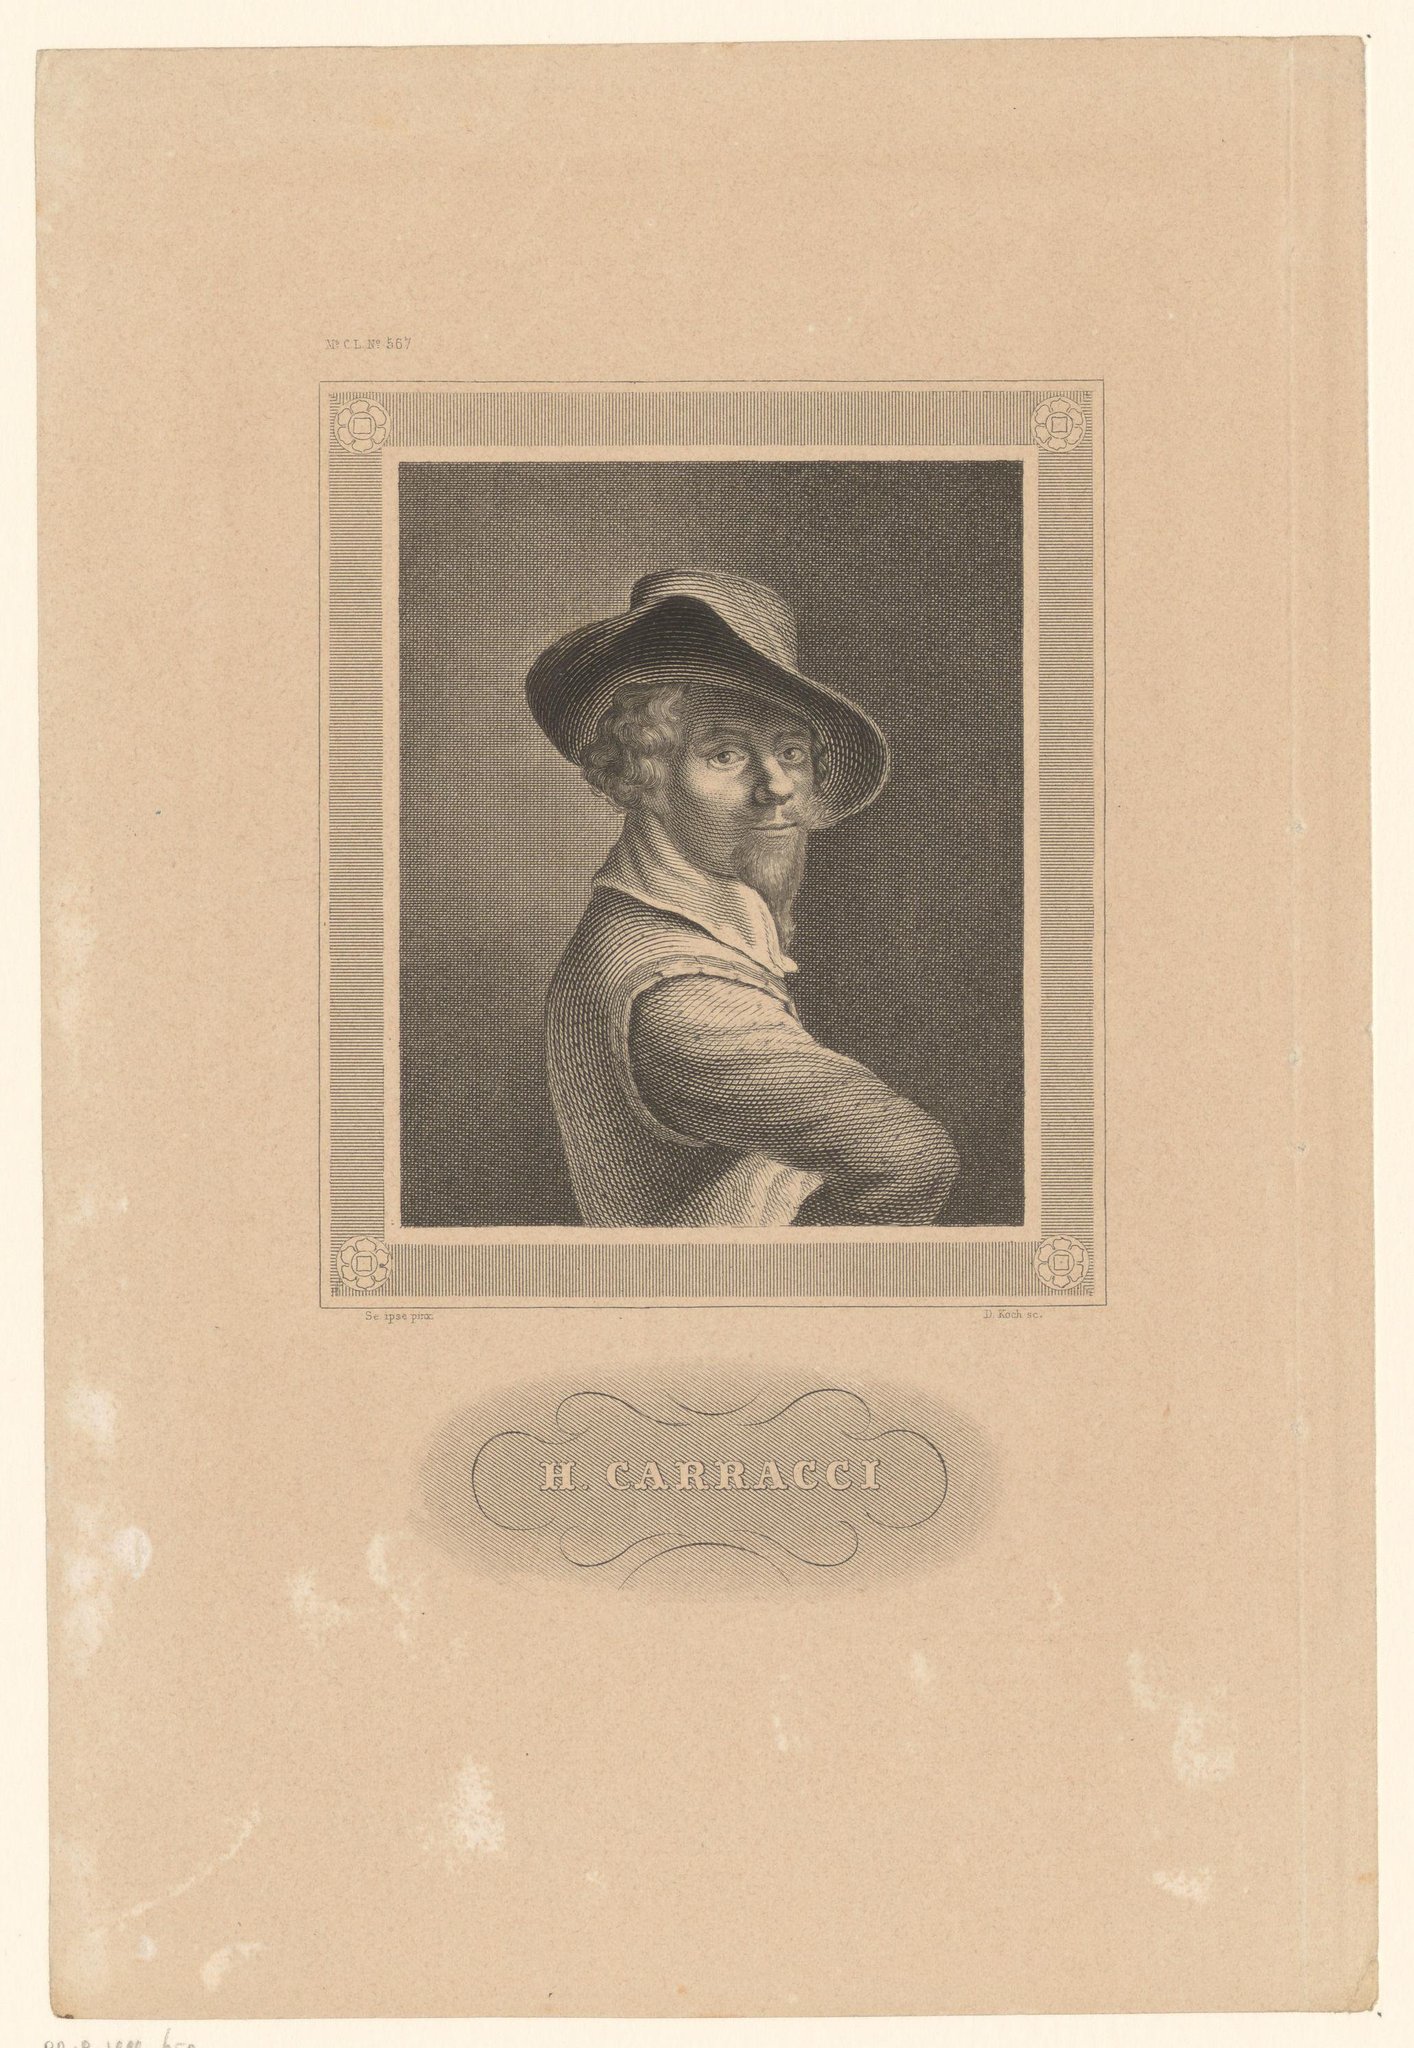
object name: book illustration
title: Portret van Annibale Carracci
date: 1840-1855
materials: paper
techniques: engraving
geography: hildburghausen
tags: rome, print maker, draughtsman, annibale carracci, historical persons, portrait, self-portrait of painter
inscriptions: collector's mark: Lugt 2228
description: Prent uit: Meyer, Joseph. Das Grosse Conversations-Lexikon für die gebildeten Stände. Hildburghausen: Bibliographisches Institut, [1840-1855].